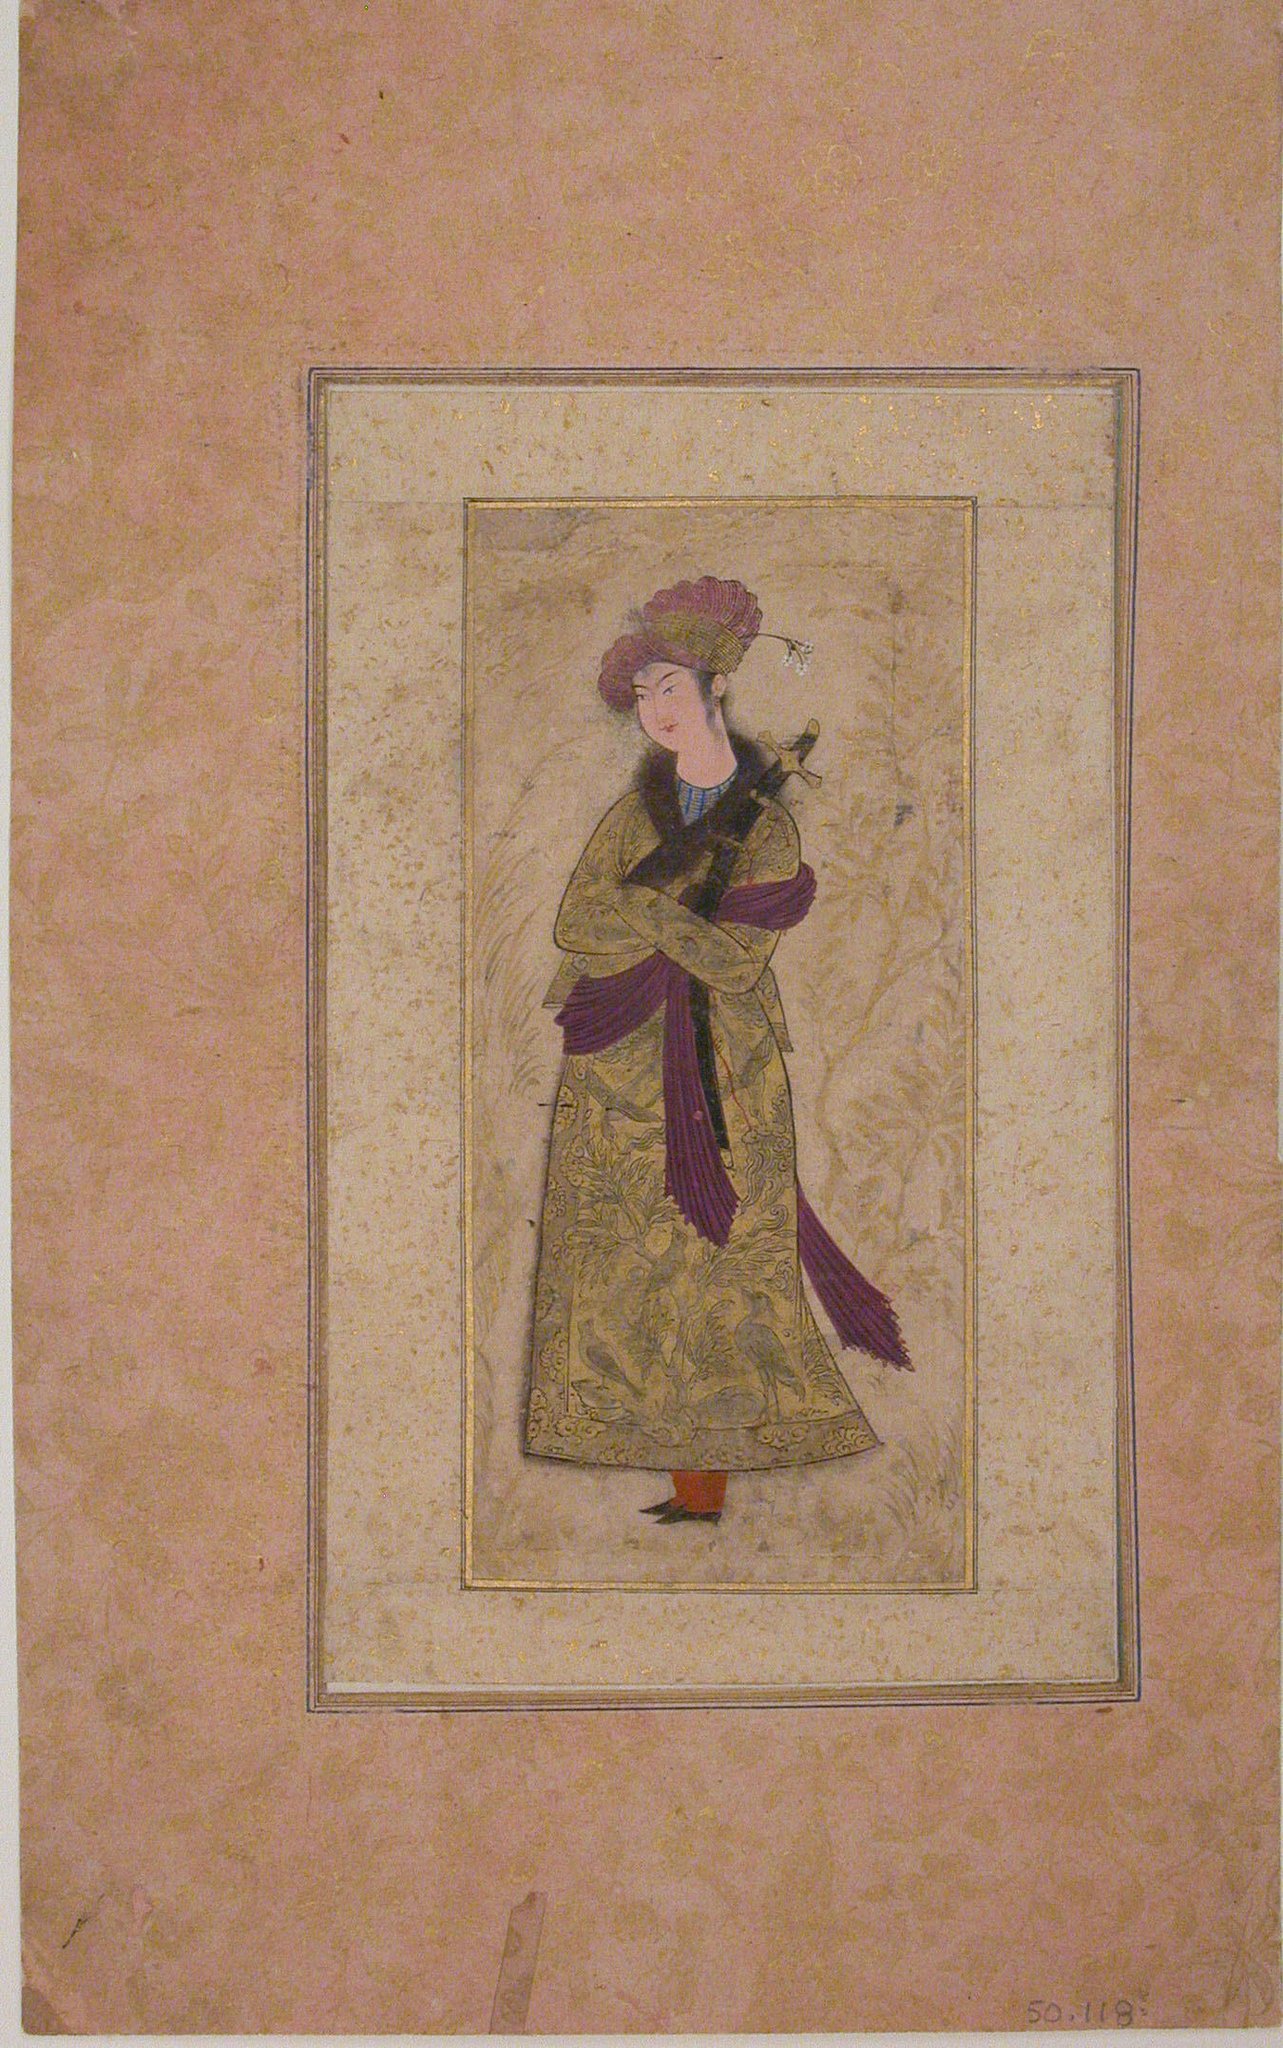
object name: illustrated album leaf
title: Portrait of a Youth Holding a Sword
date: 1601-1633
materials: paint, paper, watercolor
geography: iran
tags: swords,portraits,women